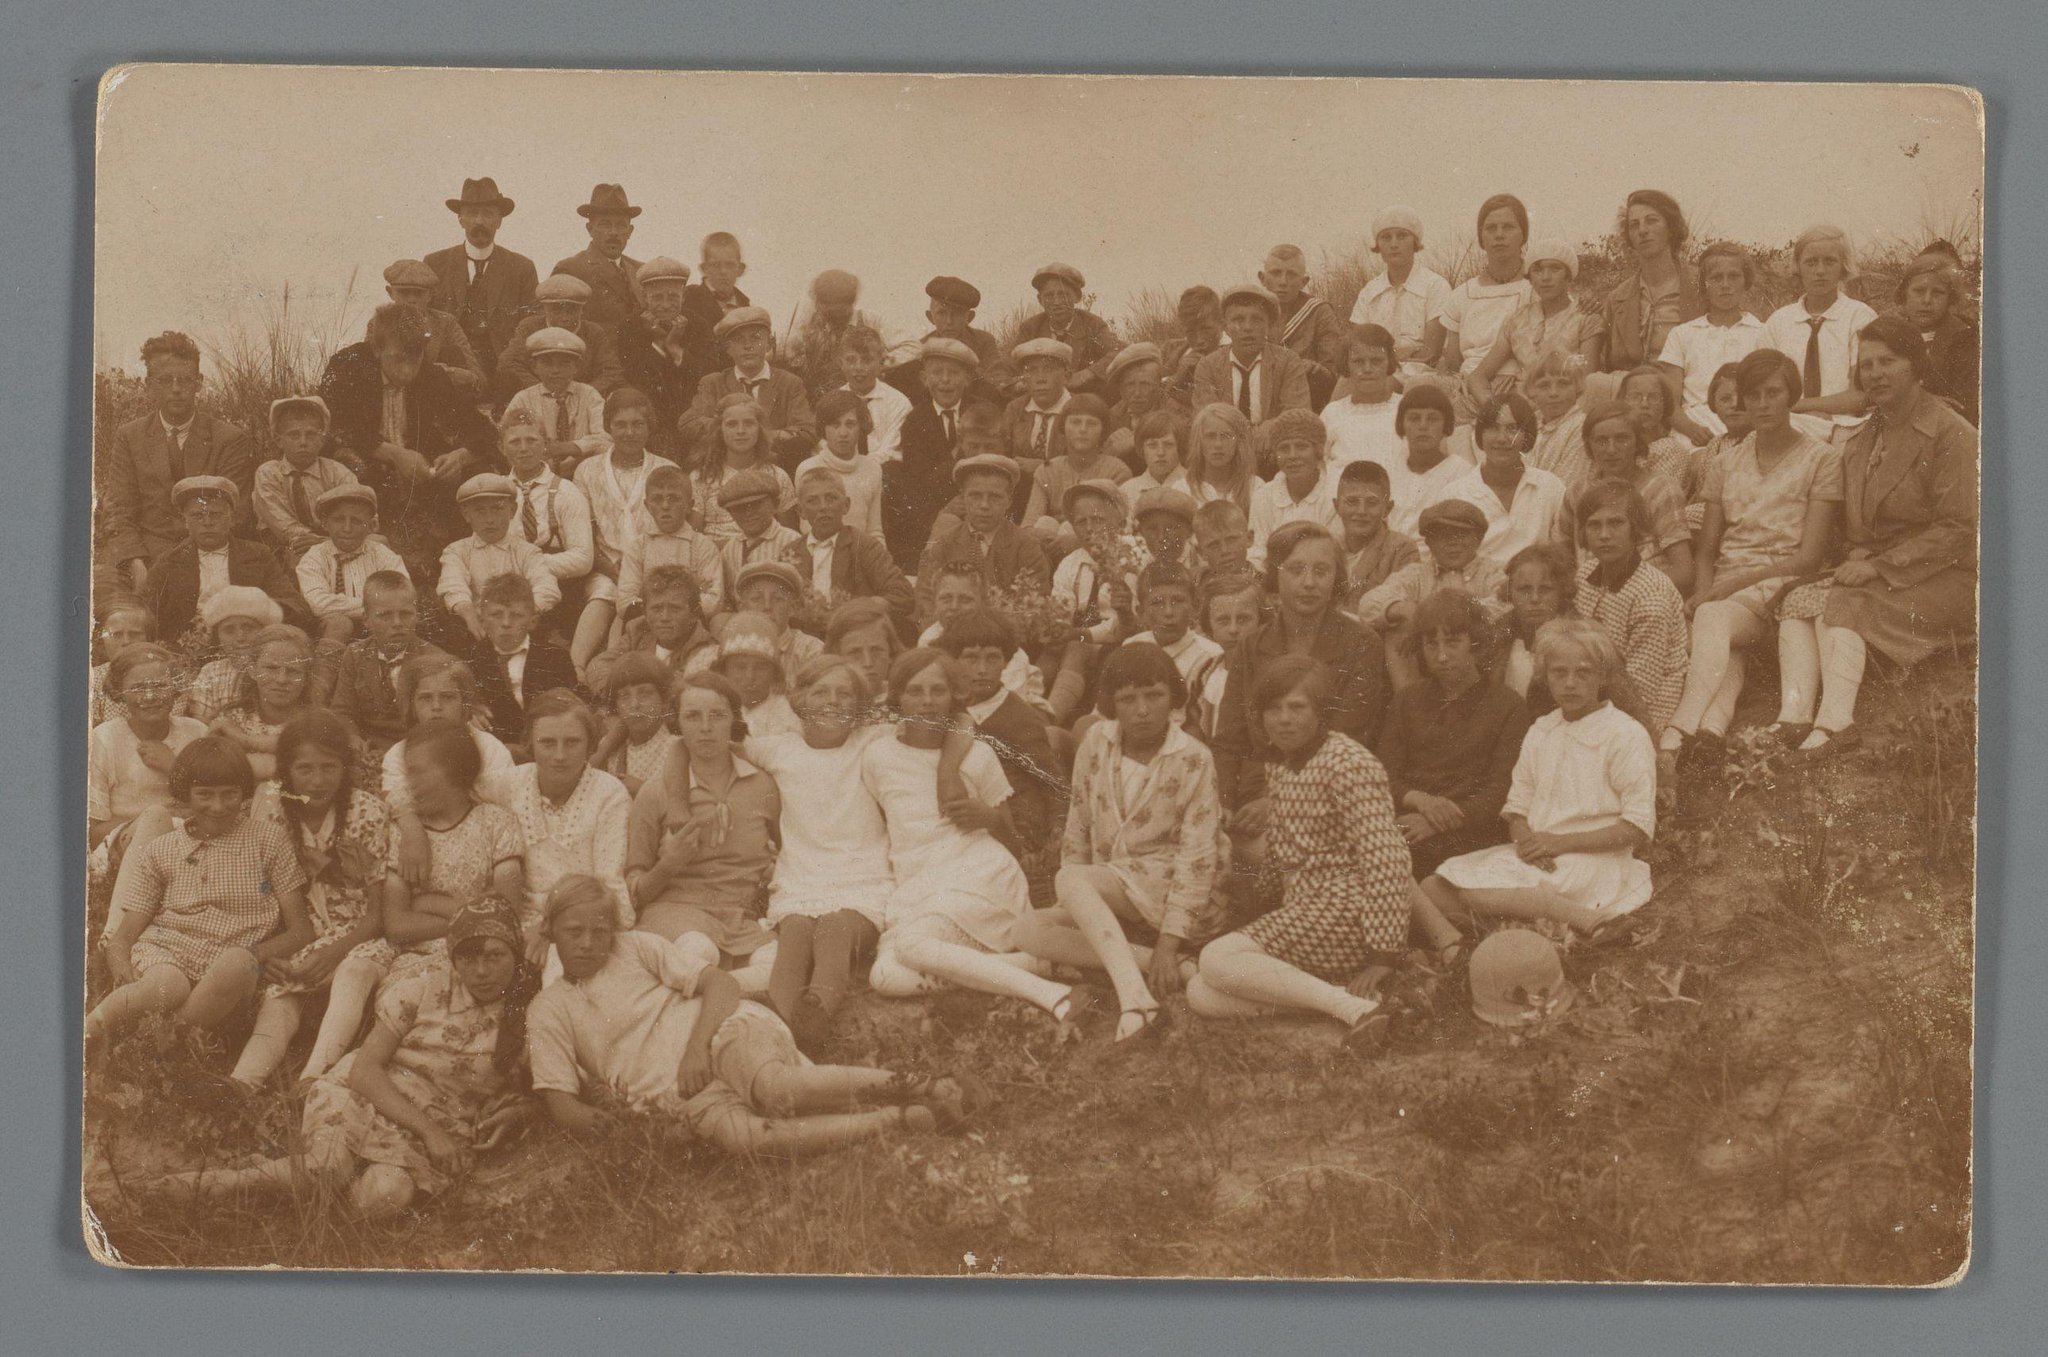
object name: ansichtkaart, prentbriefkaart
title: Groepsportret van een groep onbekende mensen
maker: Anonymous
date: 1910-1930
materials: paper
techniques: collodion silver print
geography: netherlands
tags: anonymous historical persons portrayed in a group, in a group-portrait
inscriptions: inscription: ‘klas/ Holwerk’